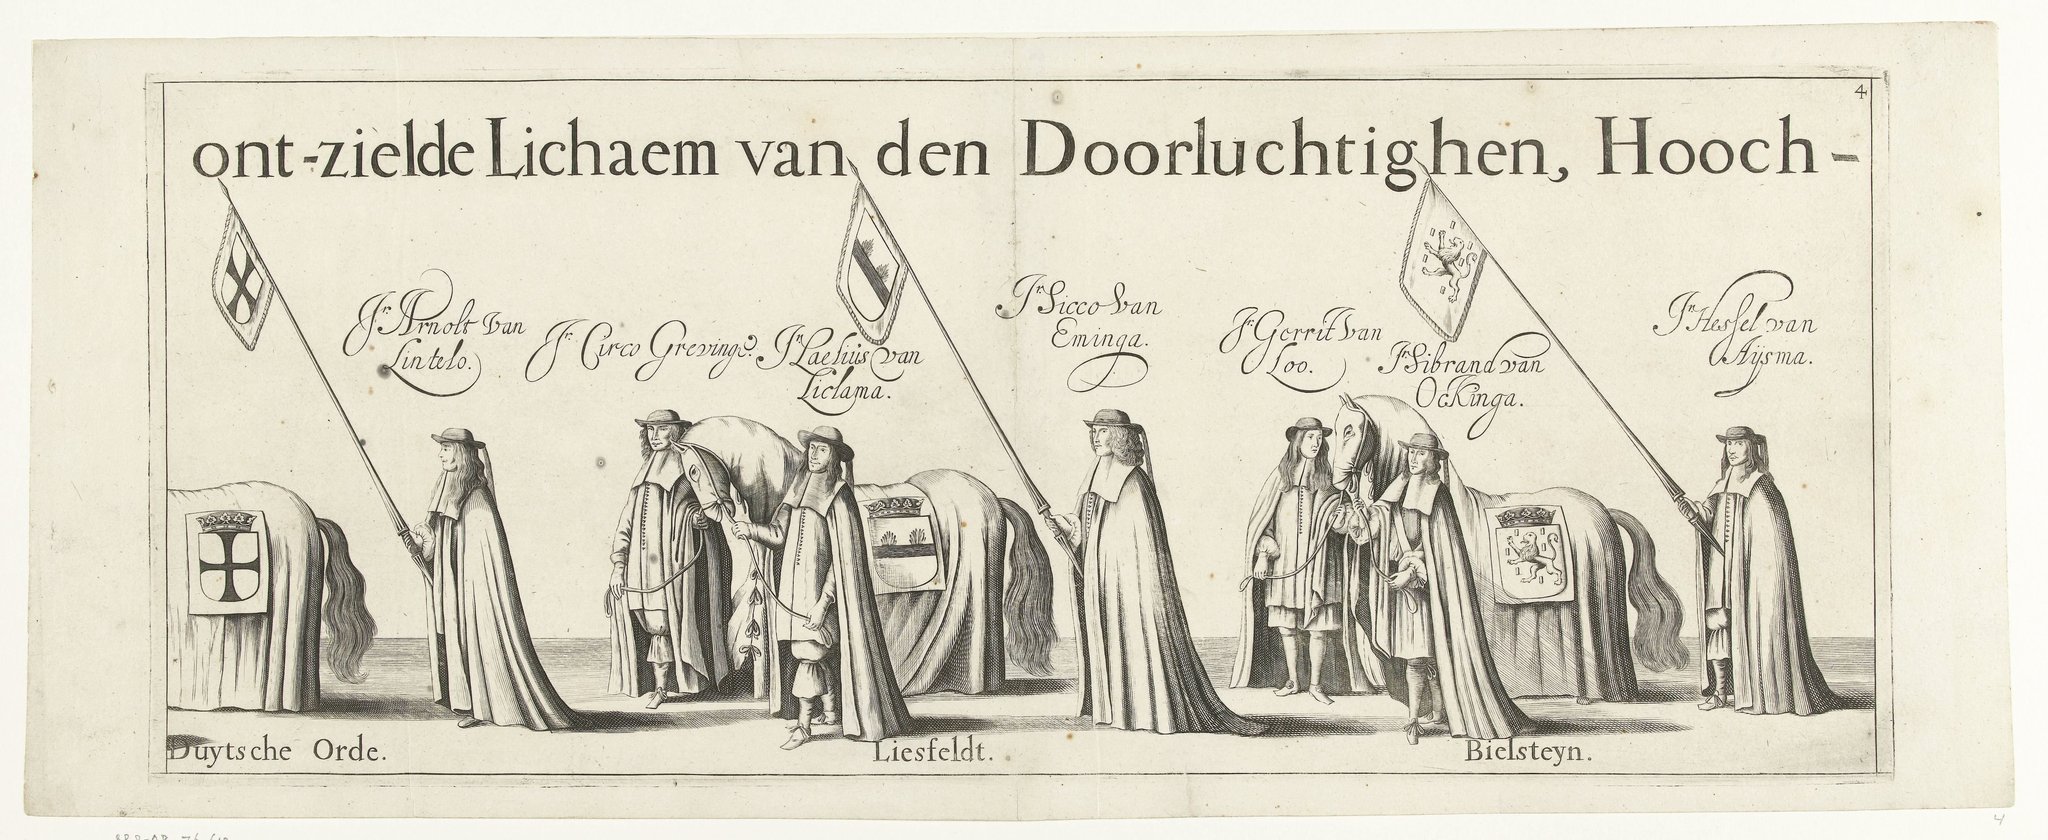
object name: print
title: Rouw-Staetelijcke Lijk-pracht in de Uyt-Vaert en Begraefenisse van het ont-zielde Lichaem van (...) Wilhelm Frederich (...) Overleden binnen Leeuwarden (...) den een-en-twintichsten October, MDCLXIV. en aldaer in 't Choor van de Jacobijner Kerck, den vyfthienden december MDCLXIV. Oude Stijl (...)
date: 1666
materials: paper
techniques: engraving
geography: leeuwarden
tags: arnhem, cortege, funeral procession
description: Begrafenisoptocht van Willem Frederik, graaf van Nassau-Dietz, in Leeuwarden op 6 januari 1665. Deel van de begrafenisstoet. Plaat nr. 4 in een ensemble van 25 ongemonteerde genummerde platen en twee tekstbladen die samen een lange fries vormen.